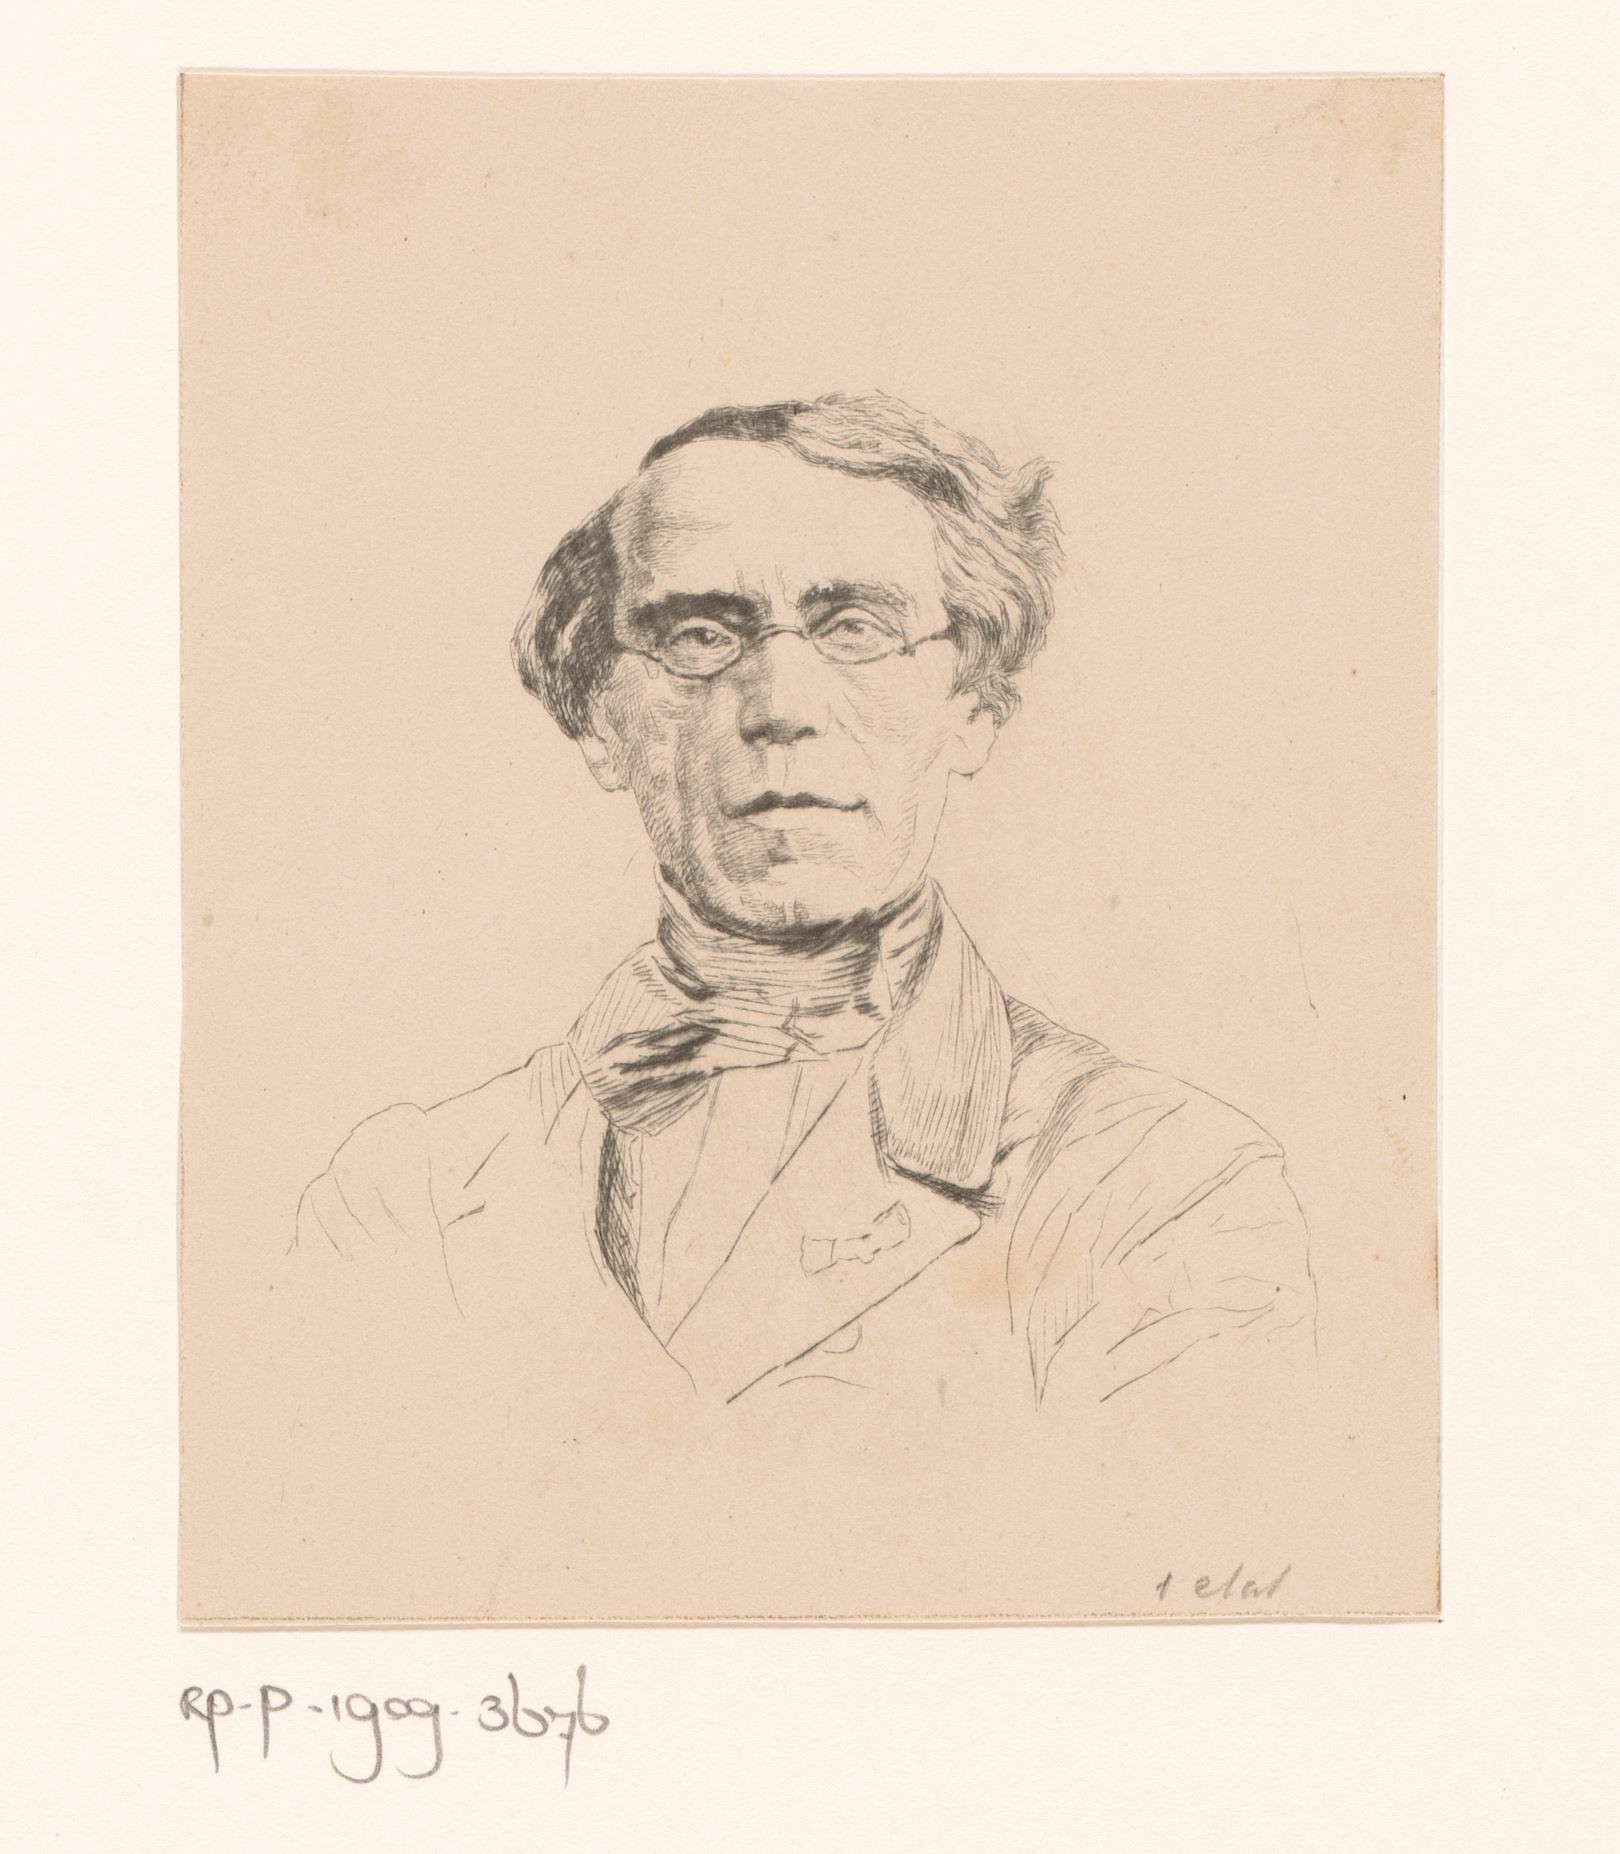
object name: print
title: Portret van een onbekende man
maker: auguste danse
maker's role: print maker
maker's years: 1829-1929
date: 1876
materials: paper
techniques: etching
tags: eyeglasses, spectacles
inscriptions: annotation: ‘1 etat’, collector's mark: Lugt 2228